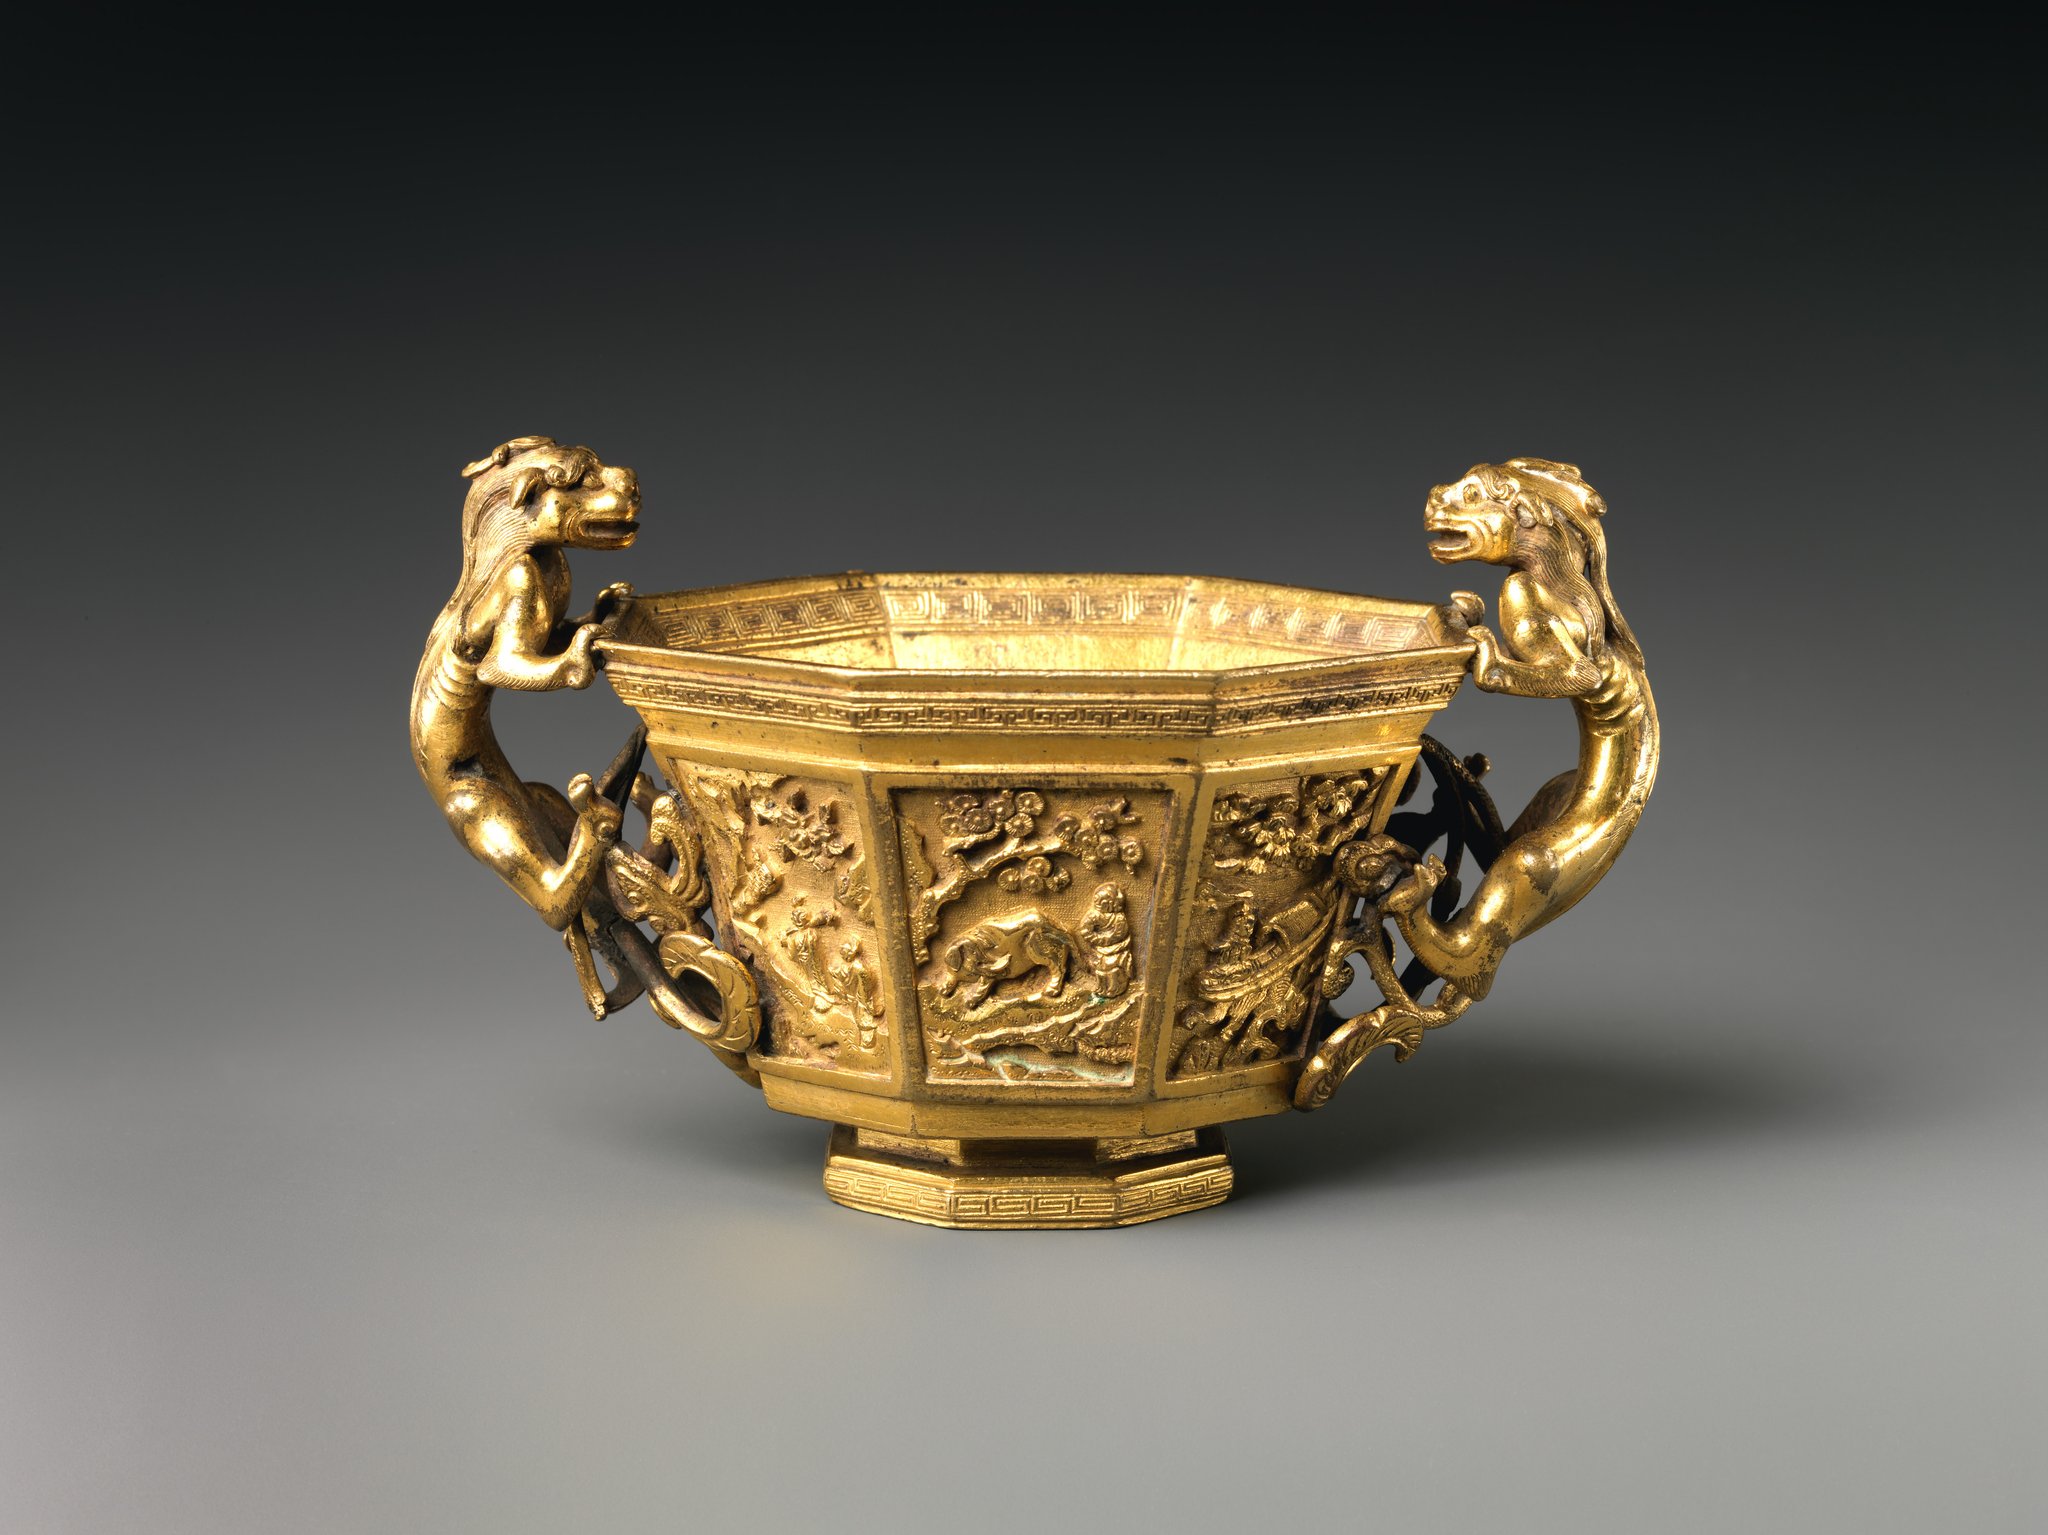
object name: cup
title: Octagonal cup with dragon handles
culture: chinese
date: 1601-1700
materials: copper alloy, gilt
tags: dragons